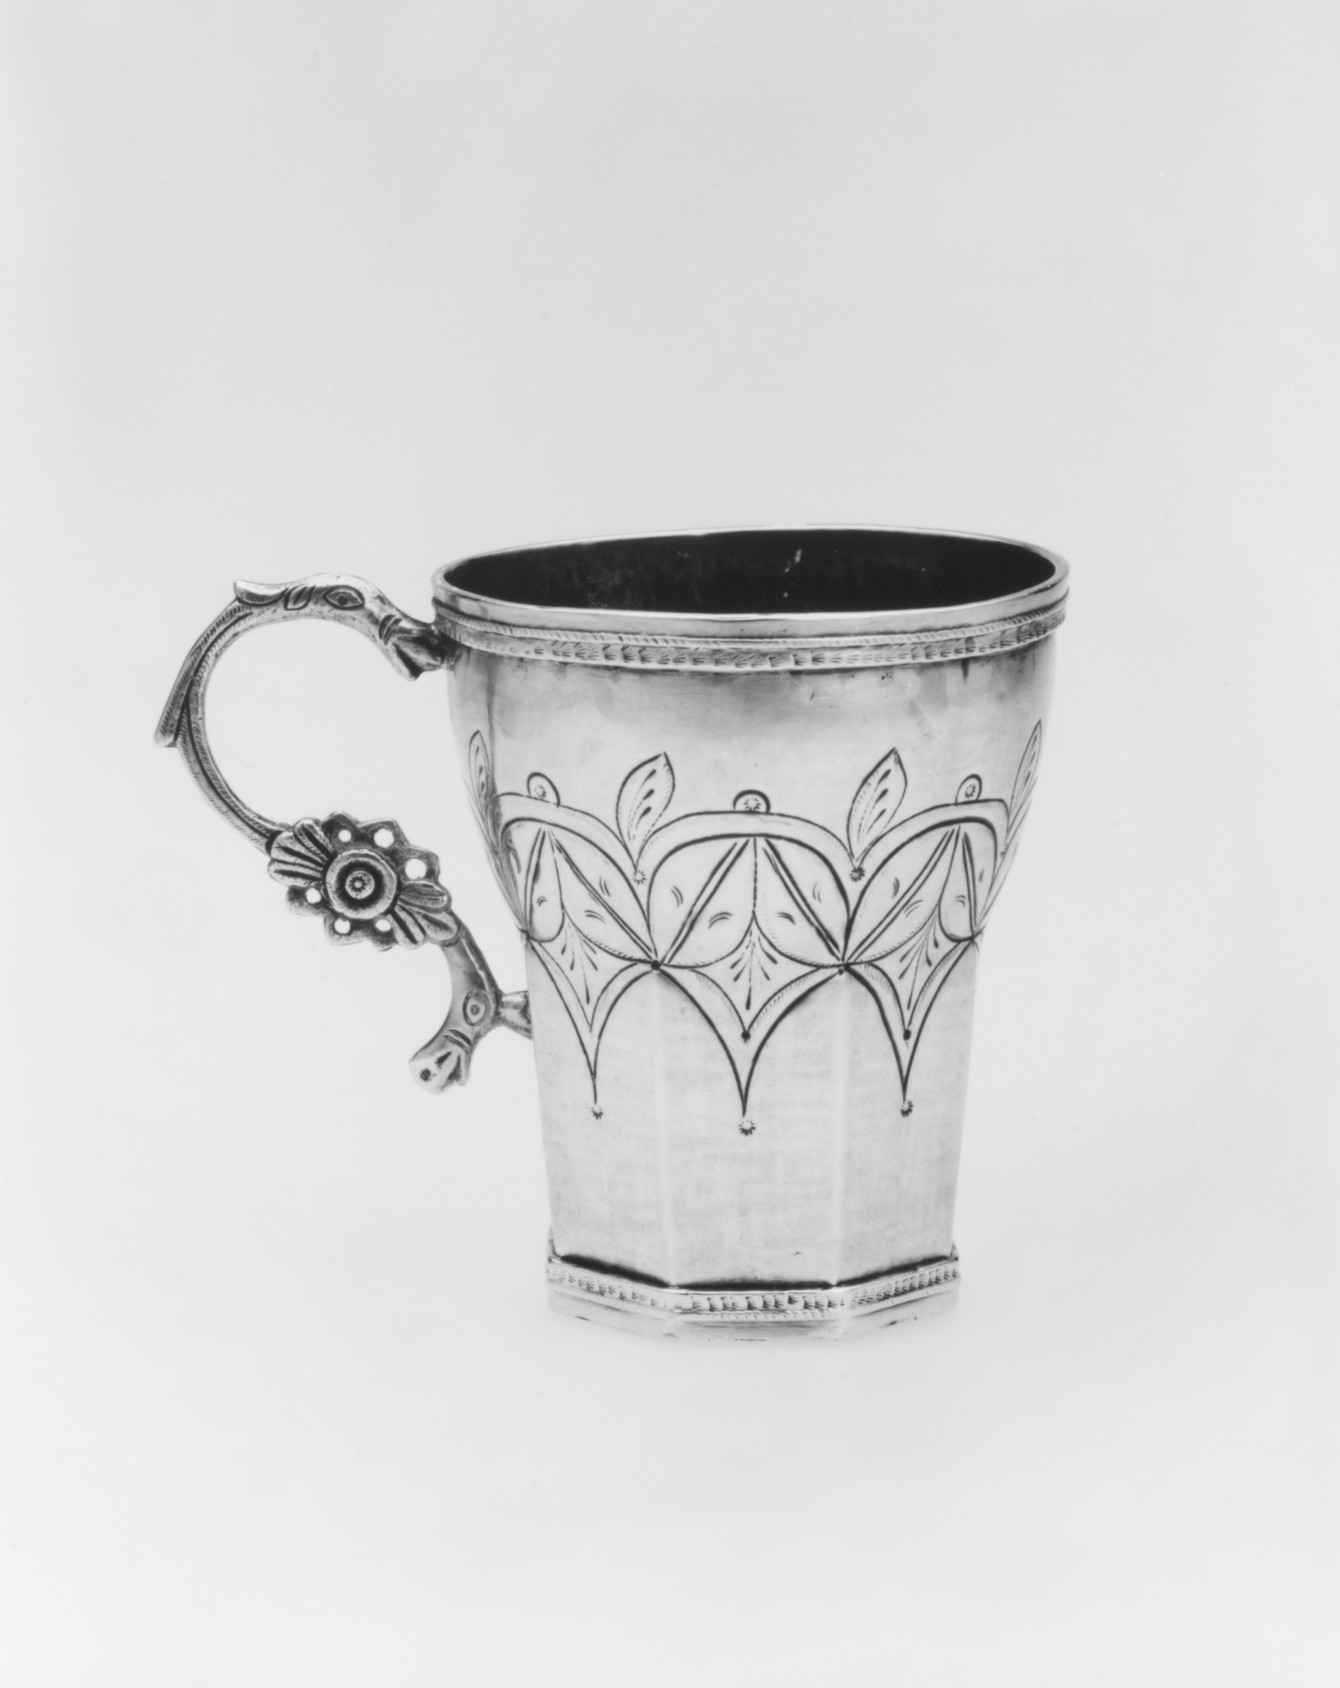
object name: mug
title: Mug (one of a pair)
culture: south american, bolivian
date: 1701-1800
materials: silver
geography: bolivia